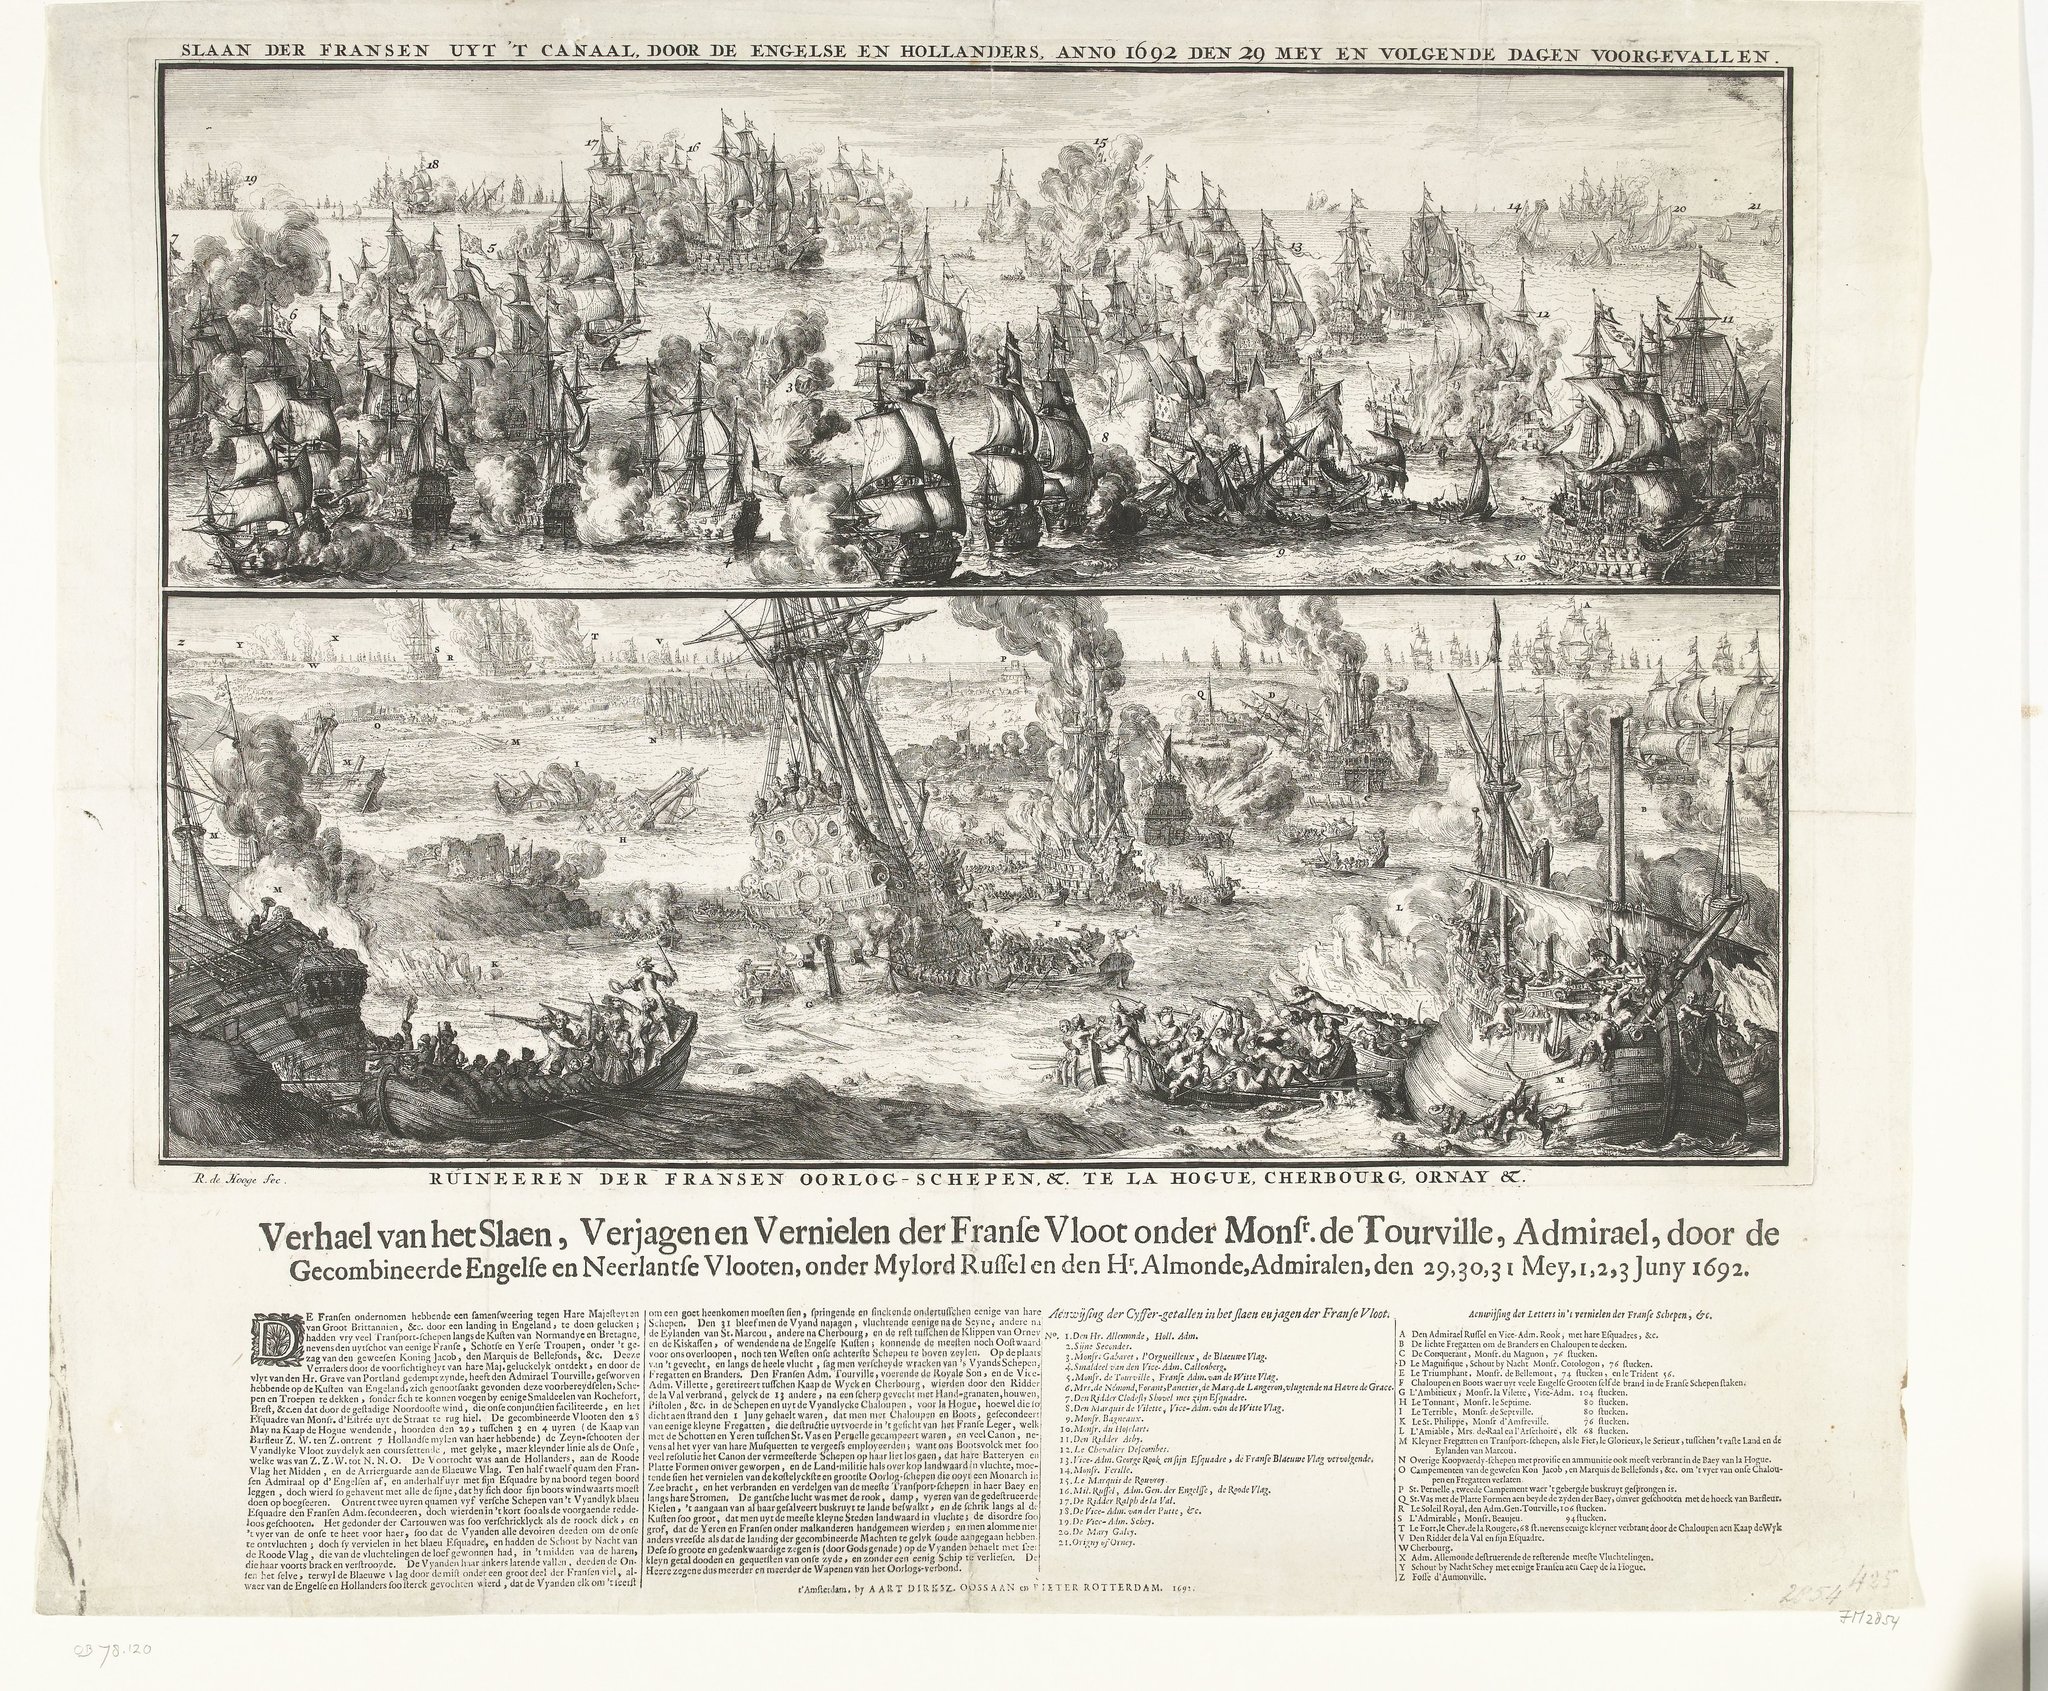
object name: print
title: De zeeslag bij Kaap La Hogue, 1692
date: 1692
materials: paper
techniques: etching, letterpress printing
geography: amsterdam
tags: paris, battle (+ naval force)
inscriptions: date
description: Aanvallen van de gecombineerde Engels-Hollandse vloten onder Russel en Almonde op de Fransen onder Tourville bij de Slag bij Kaap la Hogue, 29 mei - 3 juni 1692. Twee voorstellingen boven elkaar. Onder de prent in 4 kolommen een beschrijving van het gevecht en de legenda's 1-21 en A-Z in het Nederlands.